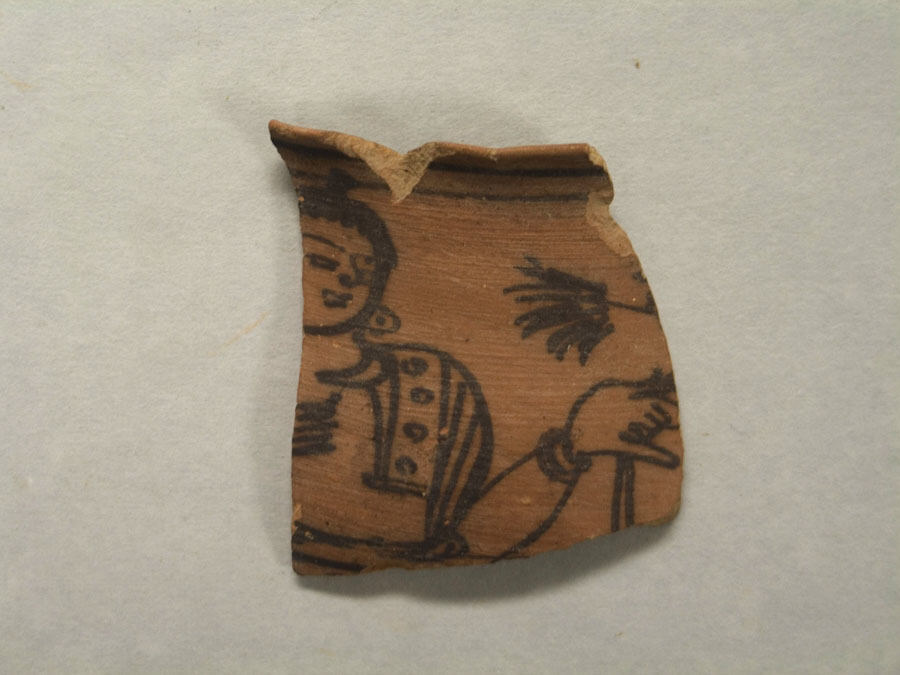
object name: shard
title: Shard with Figural Decoration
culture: pakistani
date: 301-500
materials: terracotta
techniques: painting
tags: human figures,gandhara